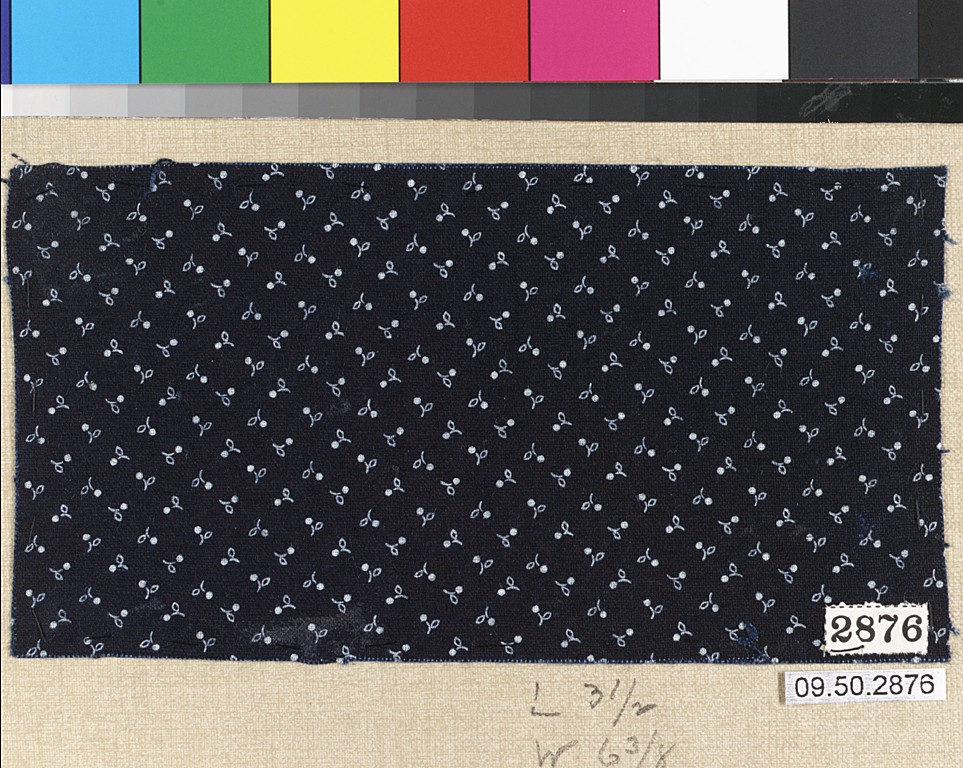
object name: piece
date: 1801-1900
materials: cotton